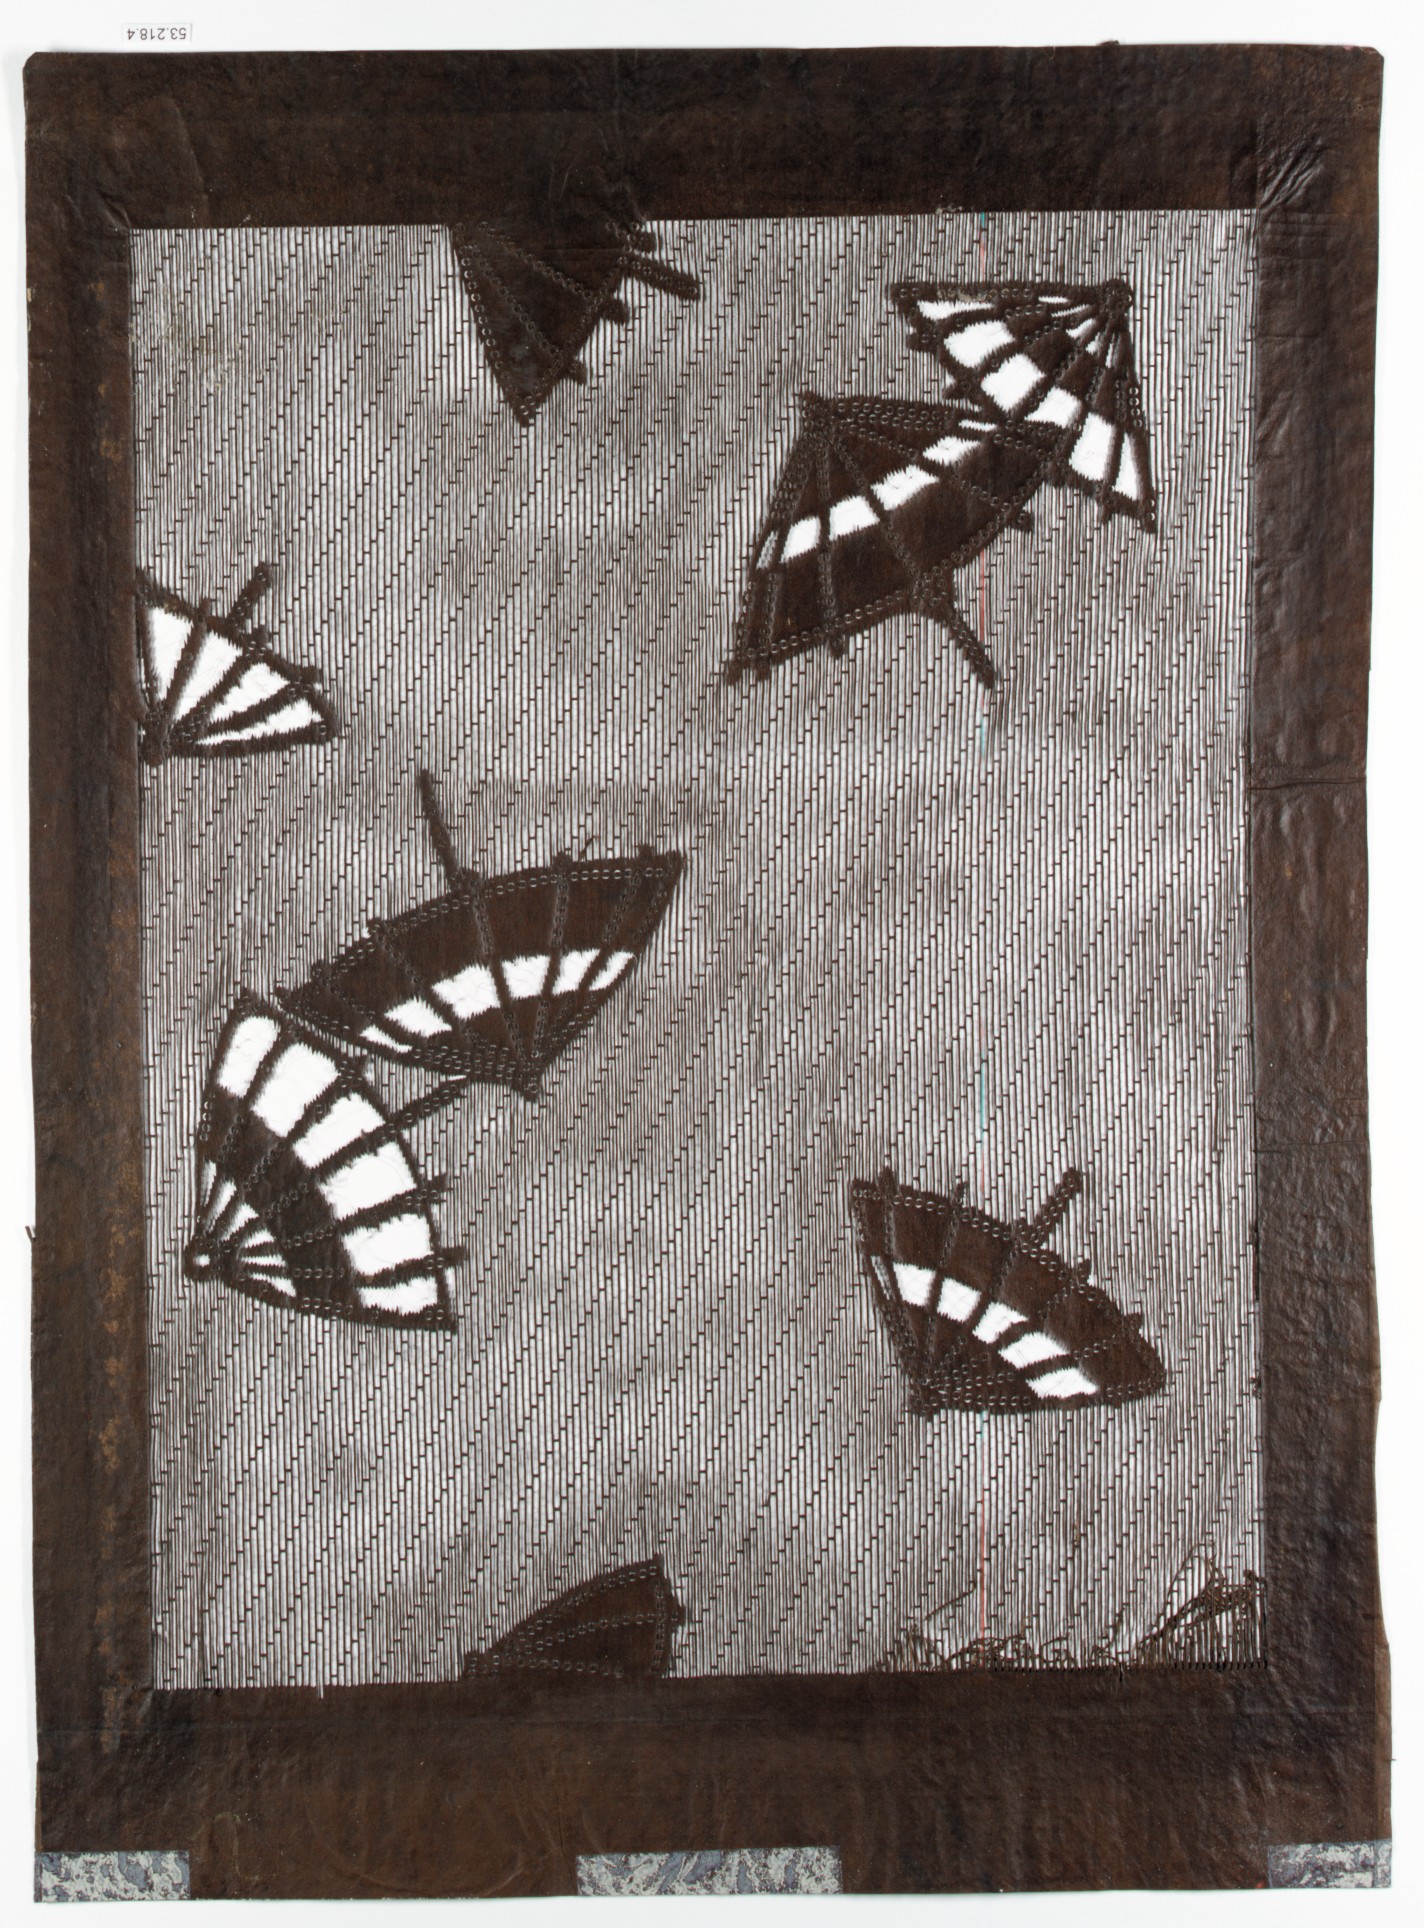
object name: stencil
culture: japanese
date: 1801-1900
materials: paper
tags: umbrellas